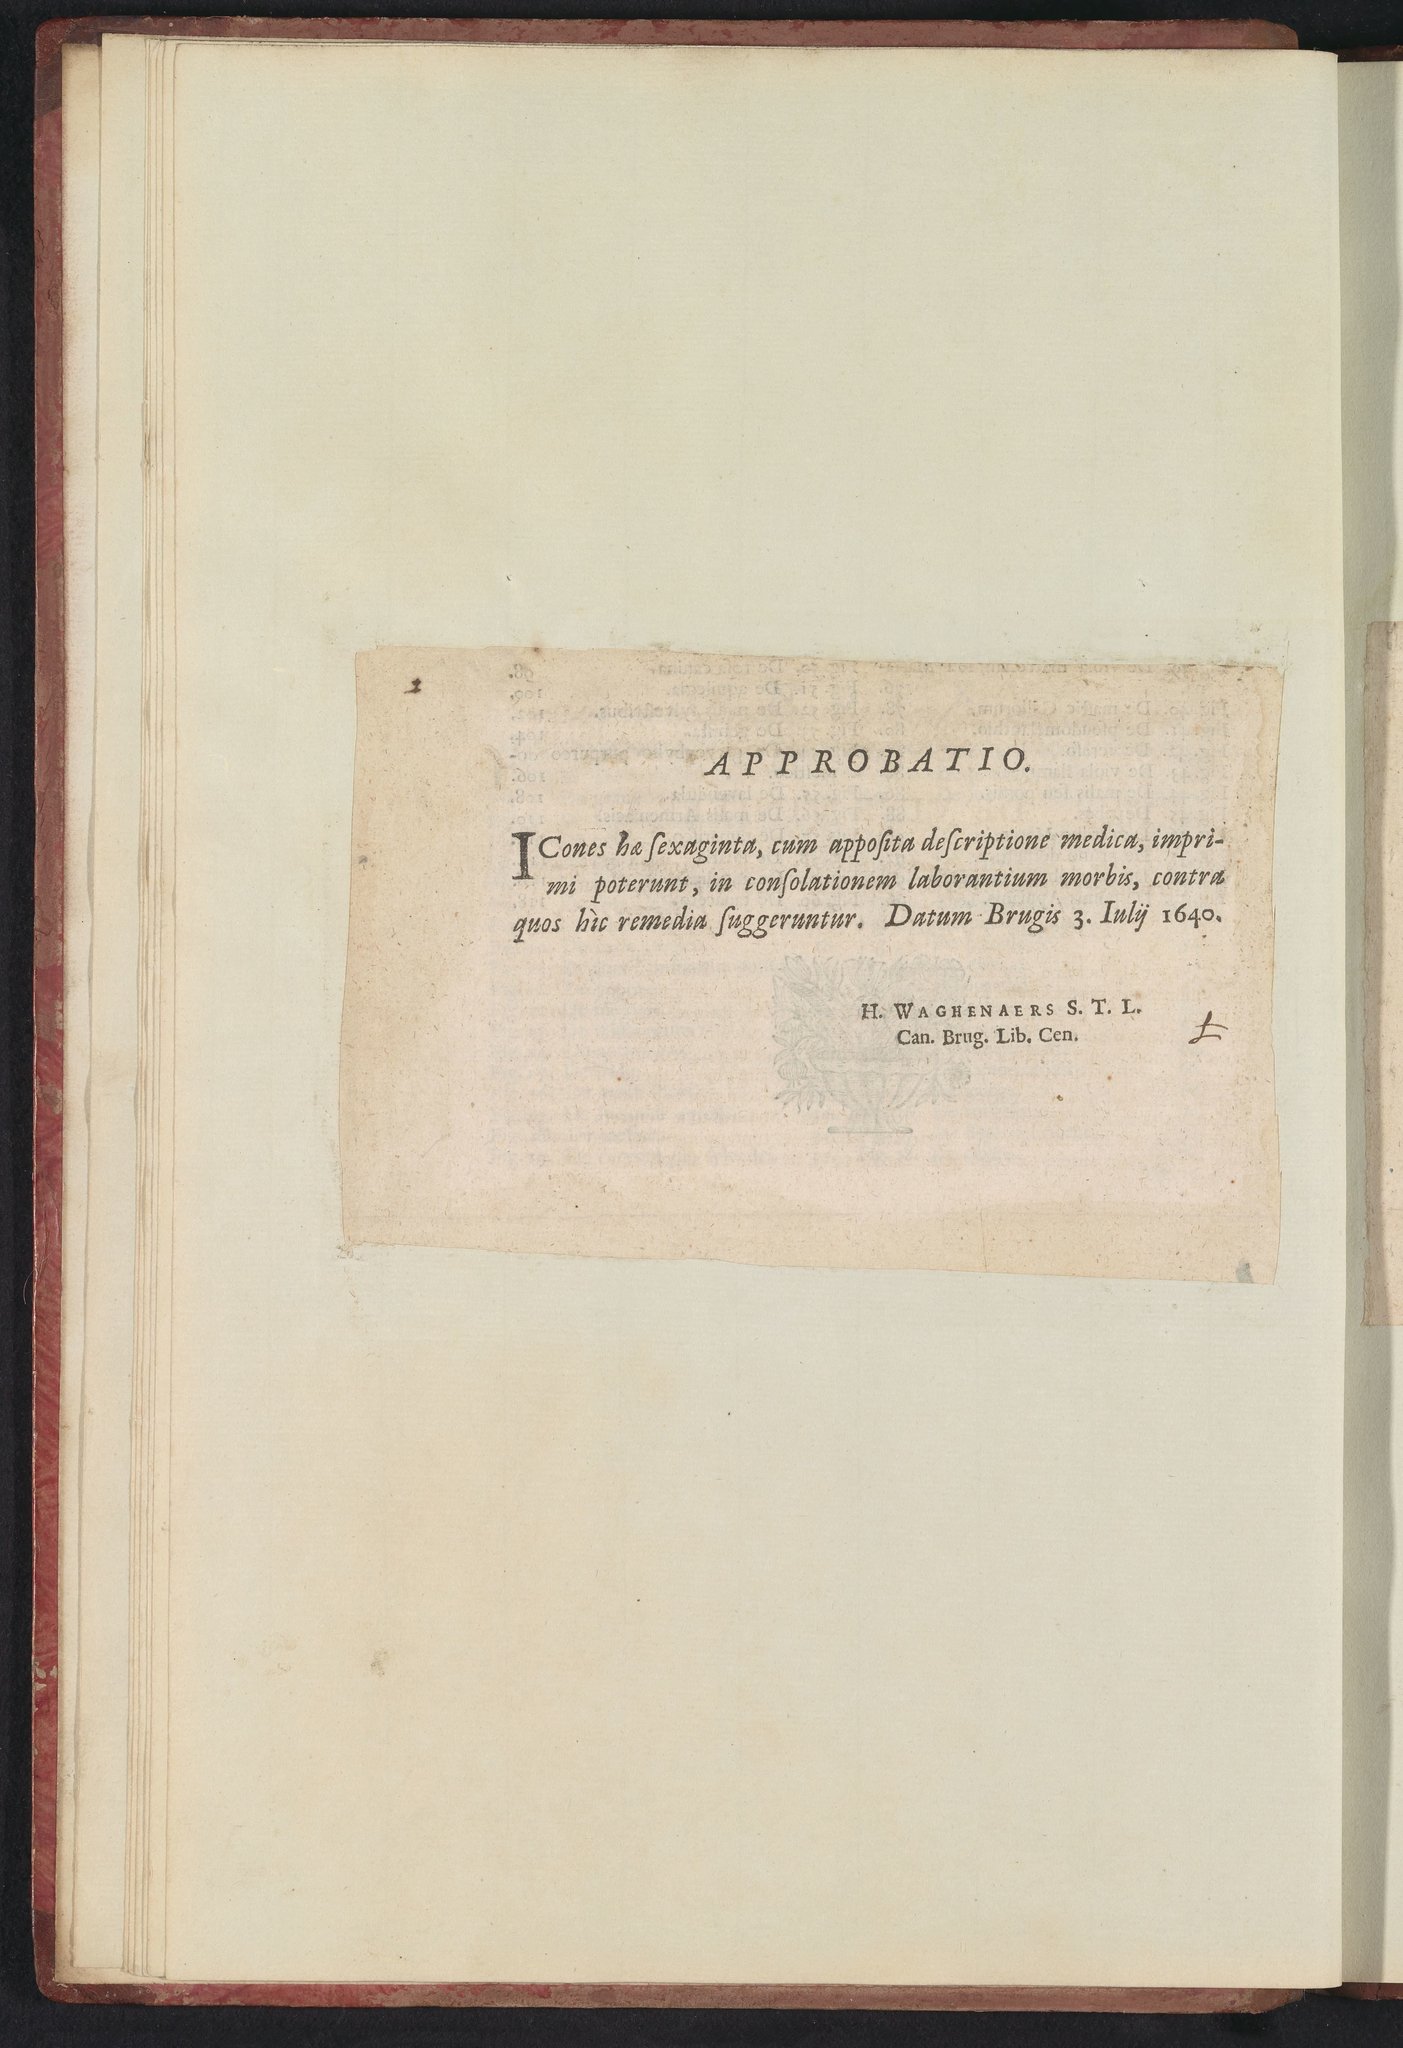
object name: text sheet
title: Approbatio in De Boodts herbarium van 1640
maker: h. waghenaers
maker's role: censor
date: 1640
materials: ink, paper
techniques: letterpress printing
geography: bruges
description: Approbatio of goedkeuring in: Anselmi Boëtii de Boot I.C. Brugensis & Rodolphi II. Imp. Roman. medici a cubiculis Florum, Herbarum, ac fructuum selectiorum icones, & vires pleraeque hactenus ignotæ. Onderdeel van het album met bladen en platen uit De Boodts herbarium van 1640. Het twaalfde van twaalf albums met aquarellen van dieren, vogels en planten bekend rond 1600, gemaakt in opdracht van keizer Rudolf II.